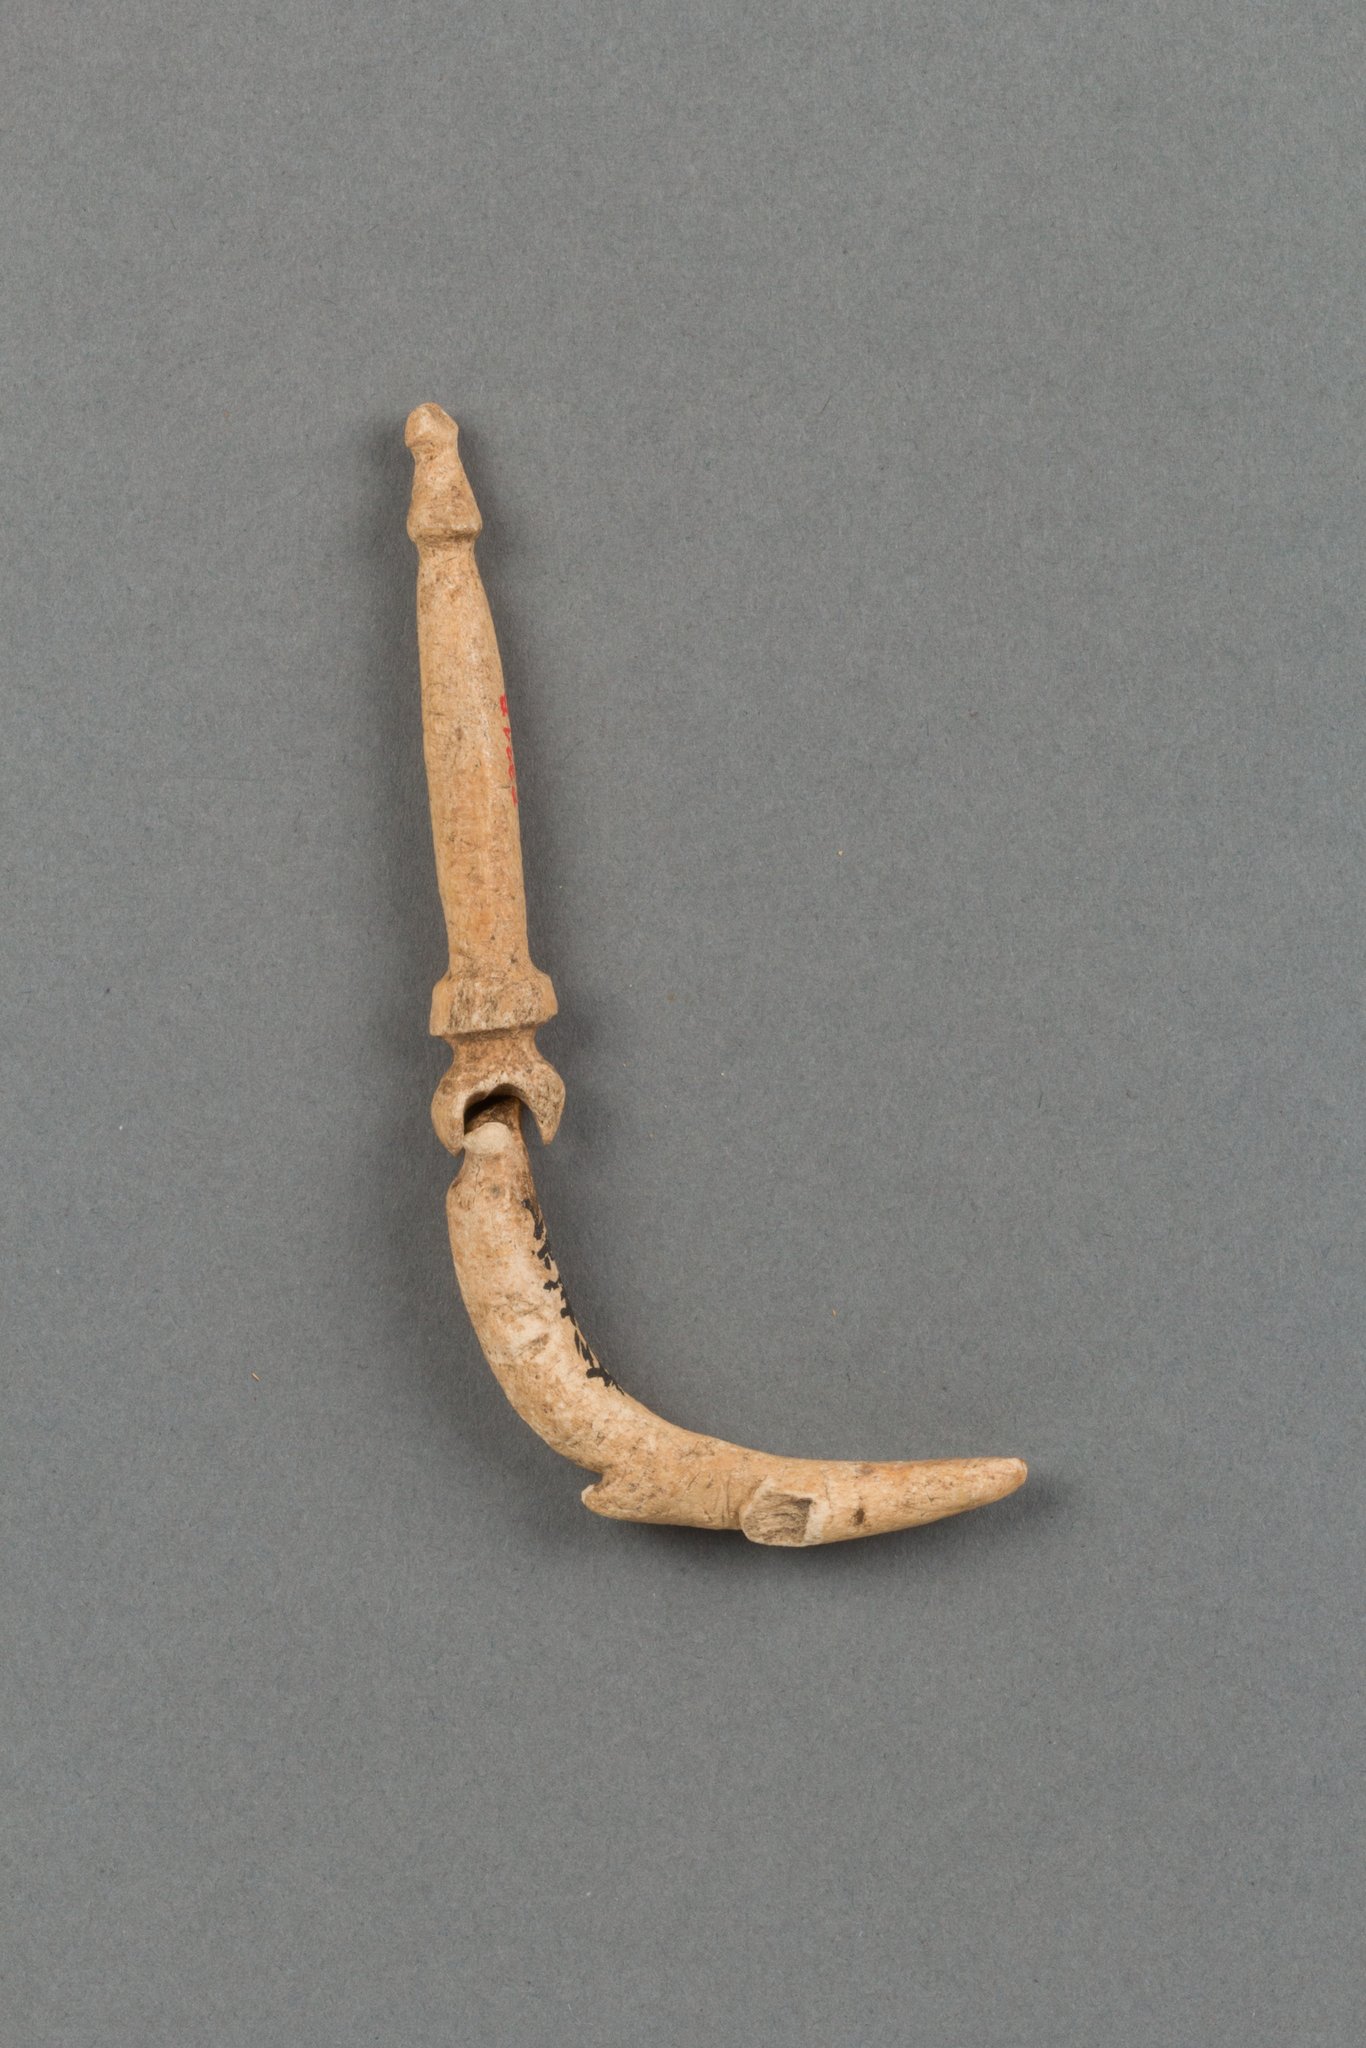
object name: fish hook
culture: japanese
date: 1200-200 BCE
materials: bone